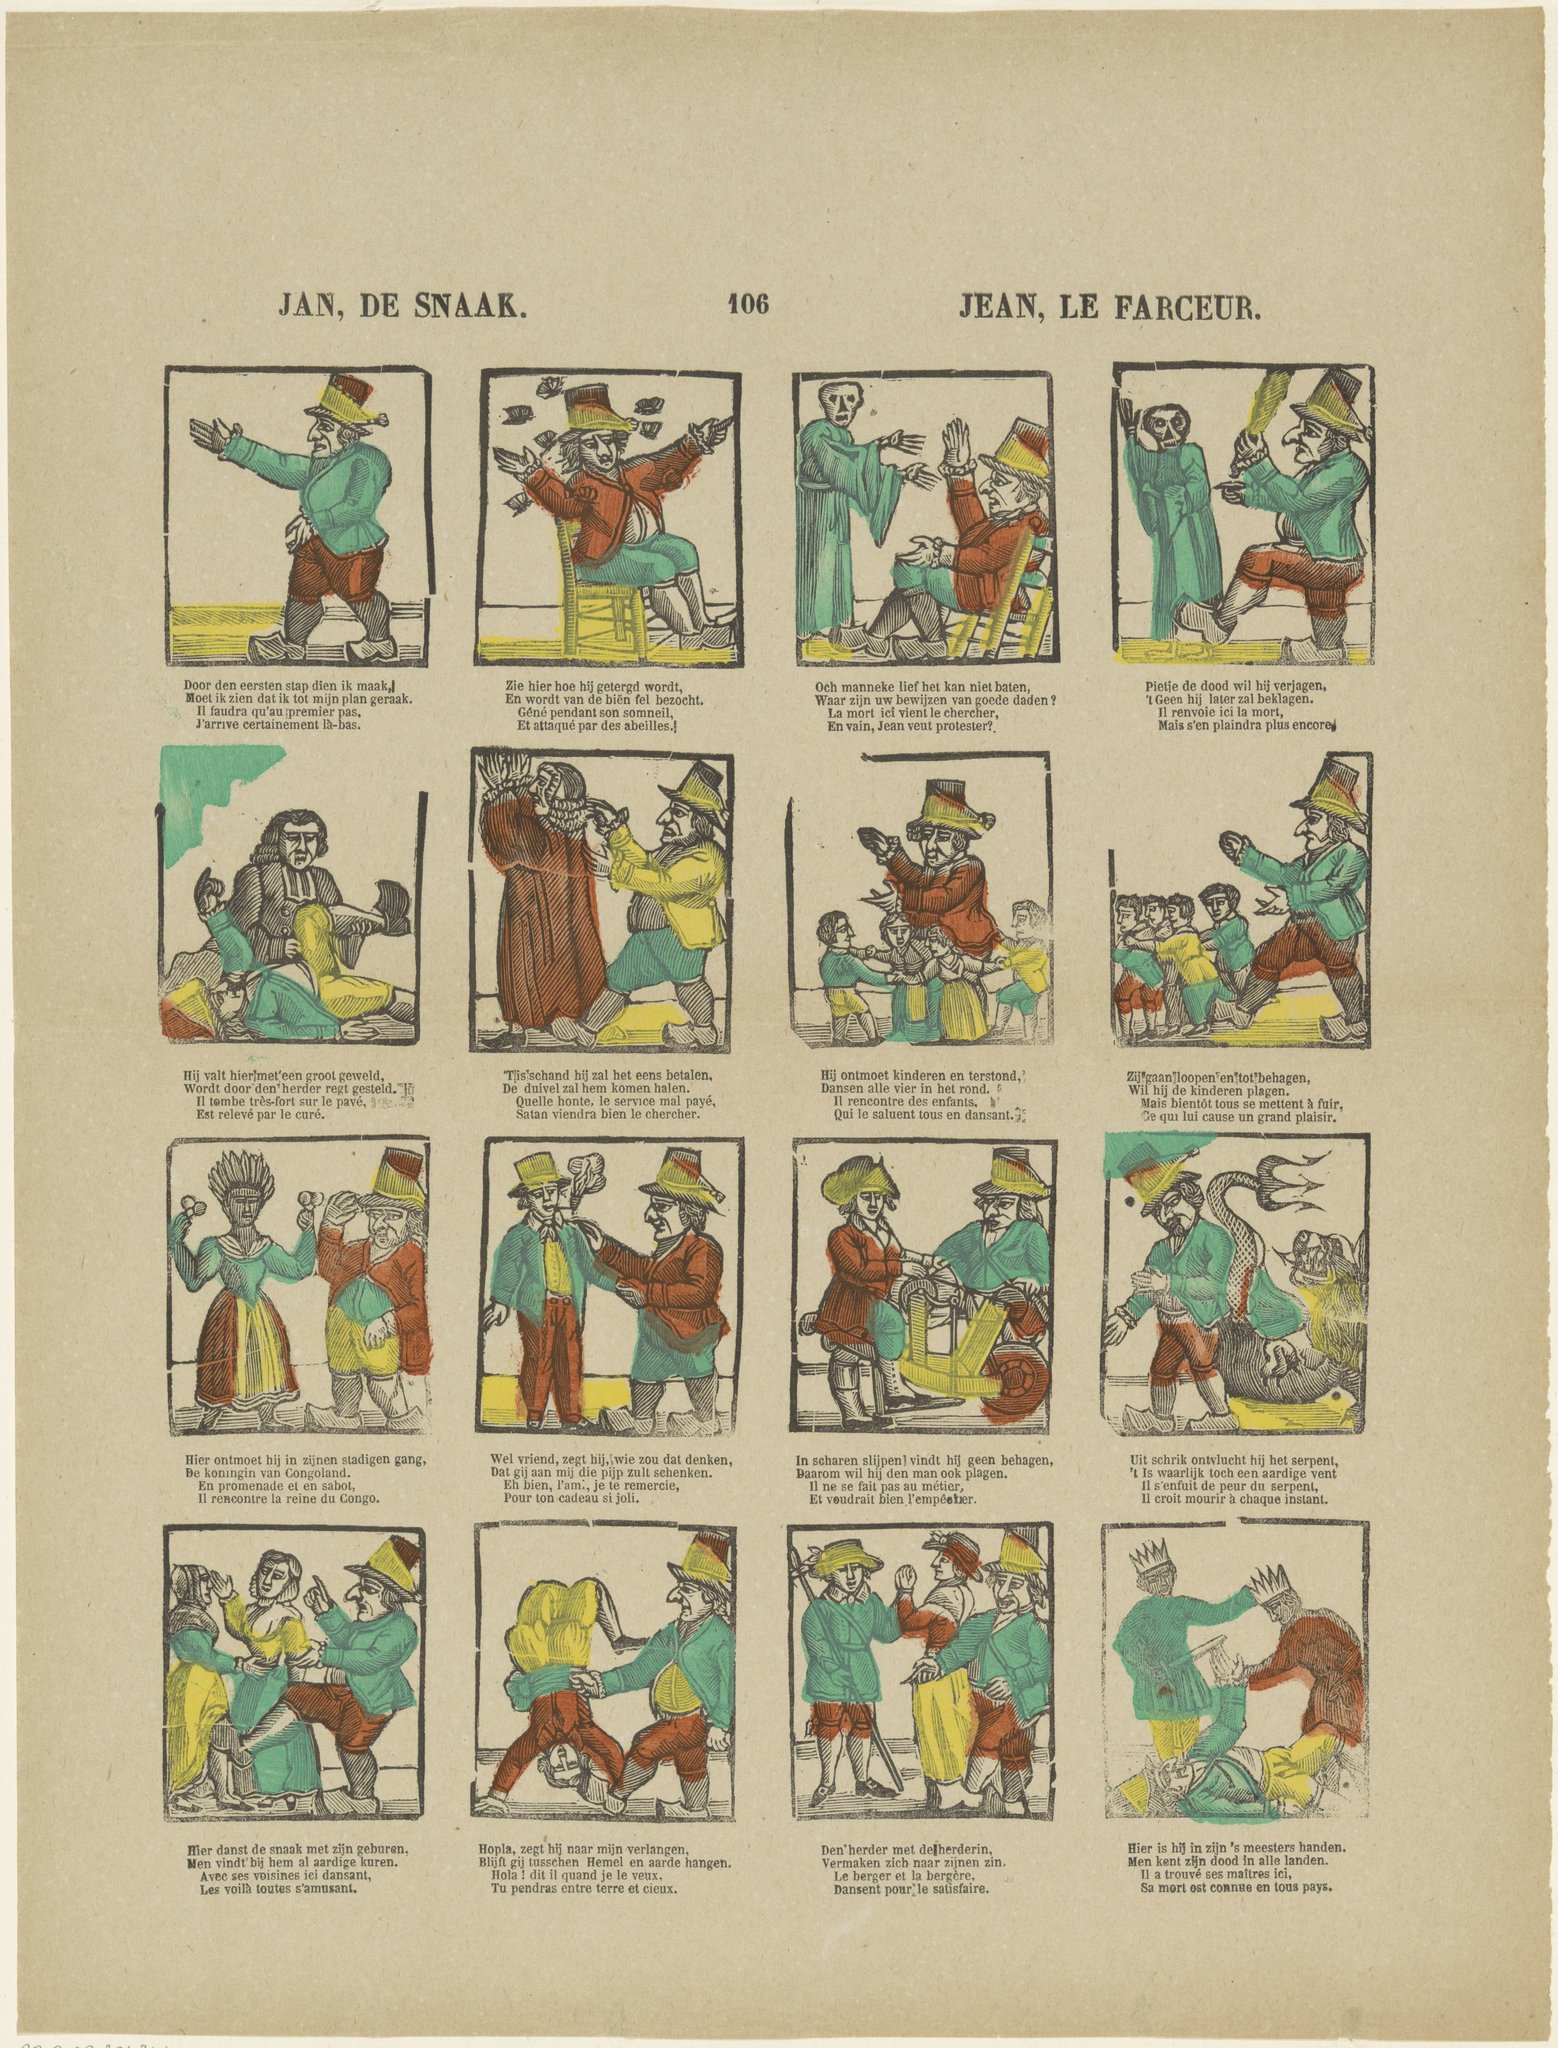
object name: print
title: Jan, de snaak / Jen, le farceur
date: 1866-1902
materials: paper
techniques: colour, letterpress printing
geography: turnhout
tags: tales and fairy tales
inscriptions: collector's mark: Lugt 2760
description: Blad met 16 voorstellingen van de kluchten van Jan Klaas. Onder elke afbeelding een tweeregelig vers in het Nederlands en in het Frans. Genummerd midden boven: 106.